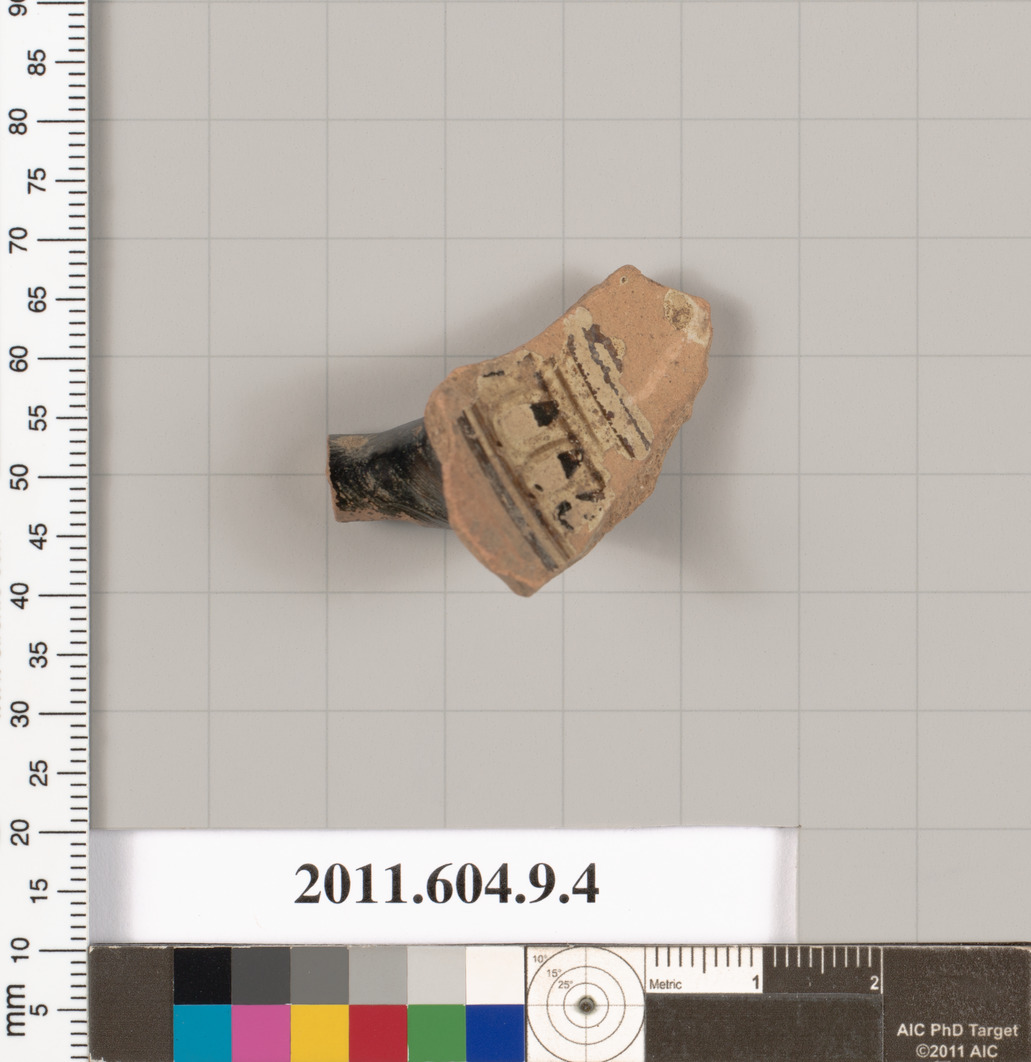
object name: kylix fragment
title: Terracotta fragment of a kylix (drinking cup)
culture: greek, laconian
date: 570-565 BCE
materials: terracotta